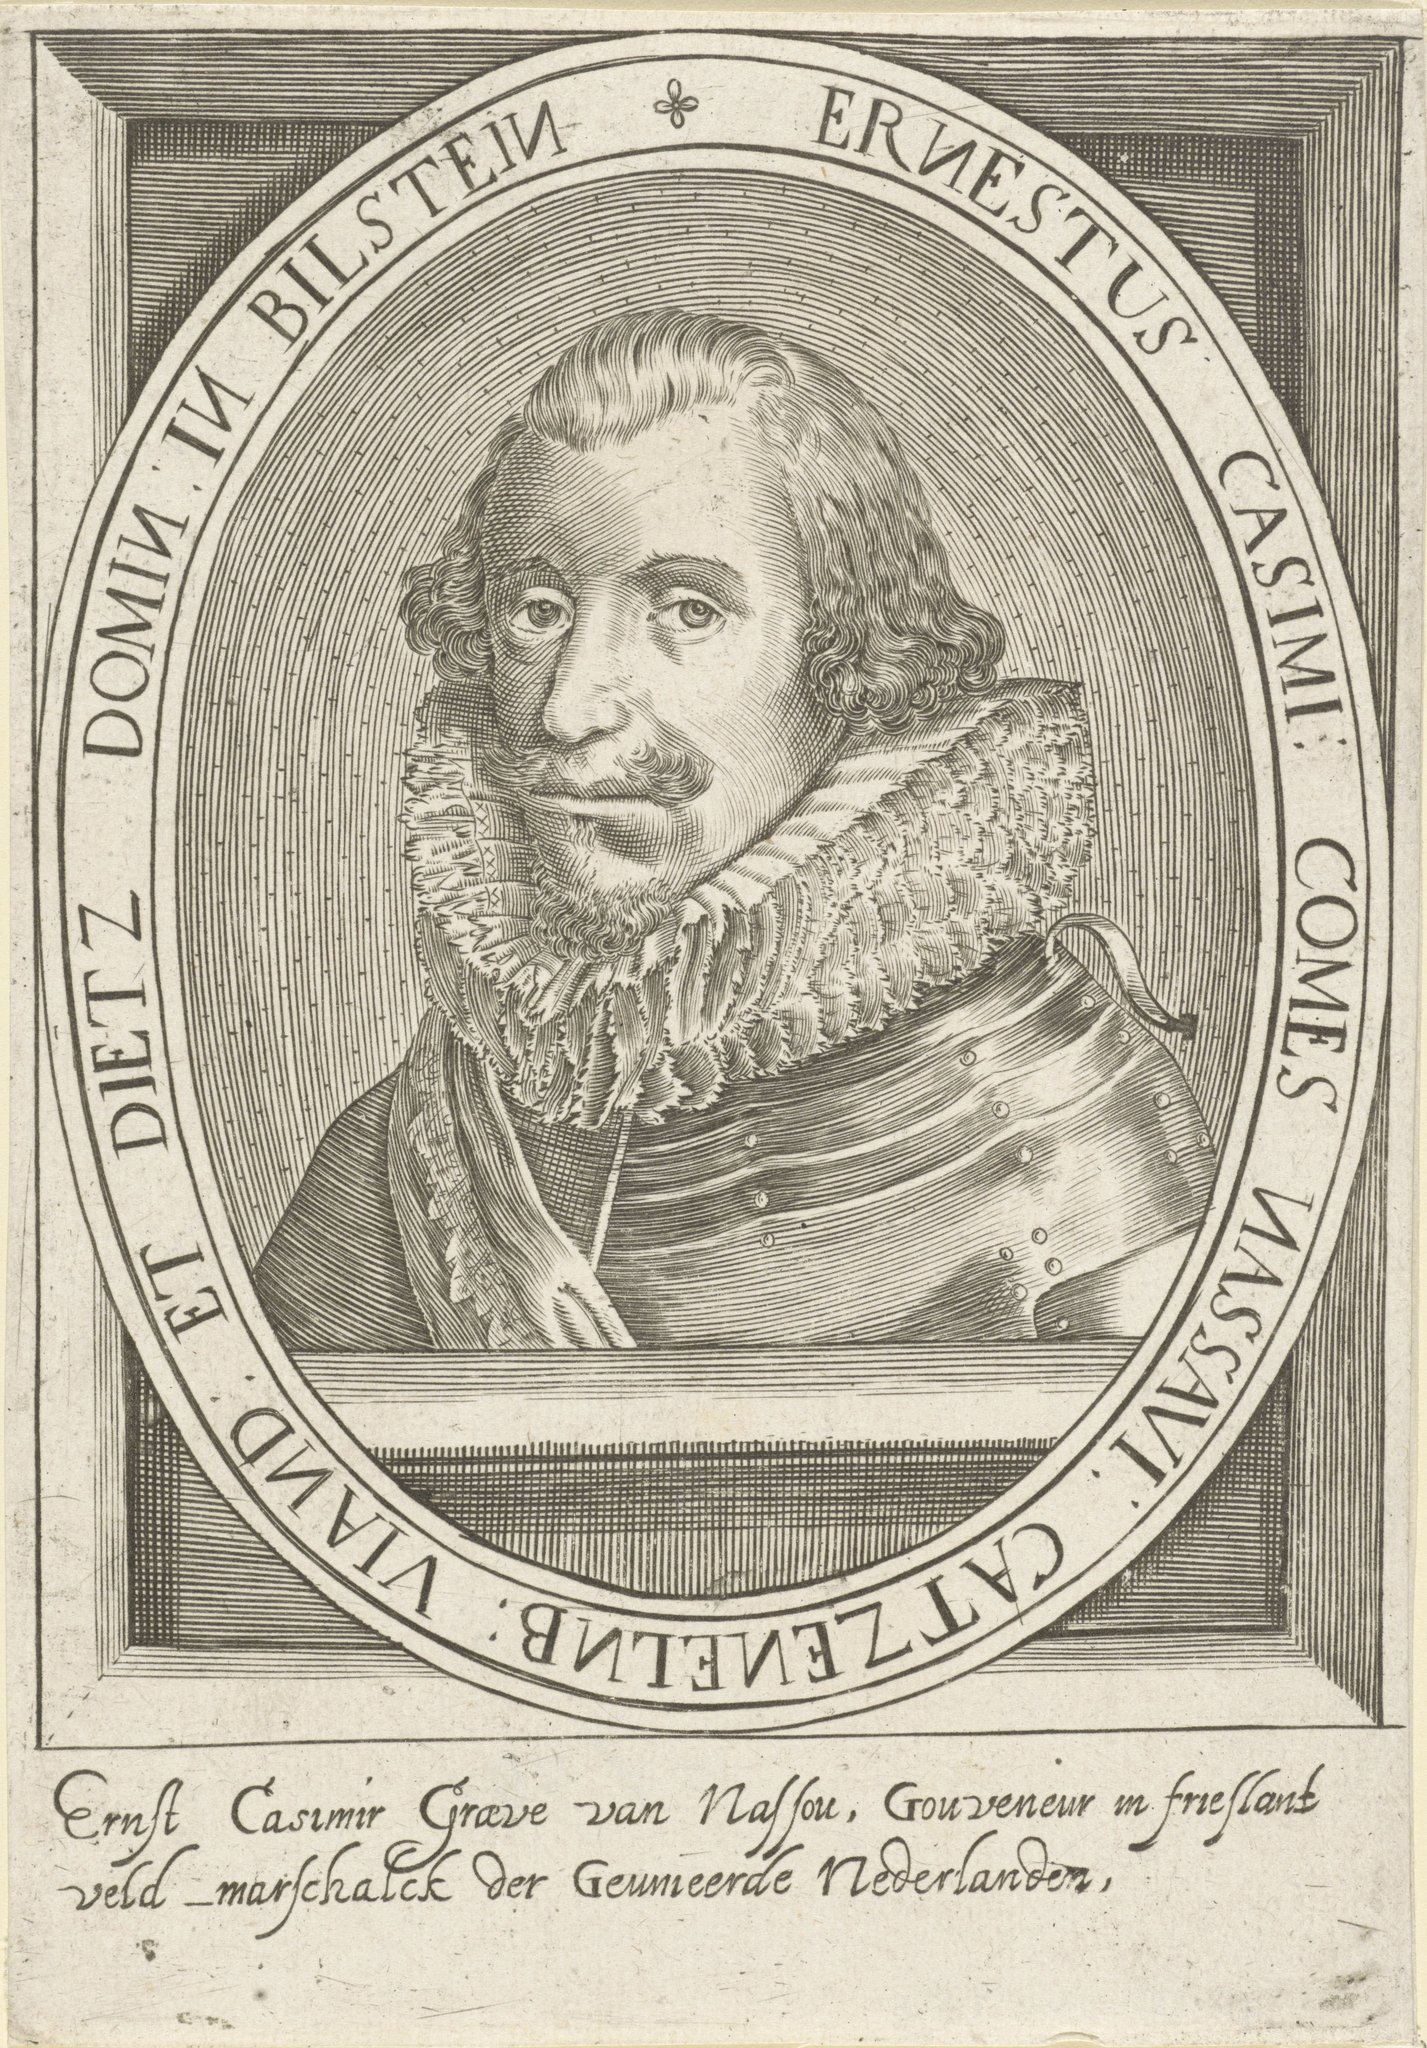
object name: print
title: Portret van Ernst Casimir, graaf van Nassau-Dietz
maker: Anonymous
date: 1600-1699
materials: paper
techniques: engraving, etching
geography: low countries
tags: ernst casimir graaf van nassau-dietz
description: De hier vermelde titel verwijst naar de hoogst verkregen titel van de geportretteerde, niet per se naar de titel die de geportretteerde op deze voorstelling draagt.